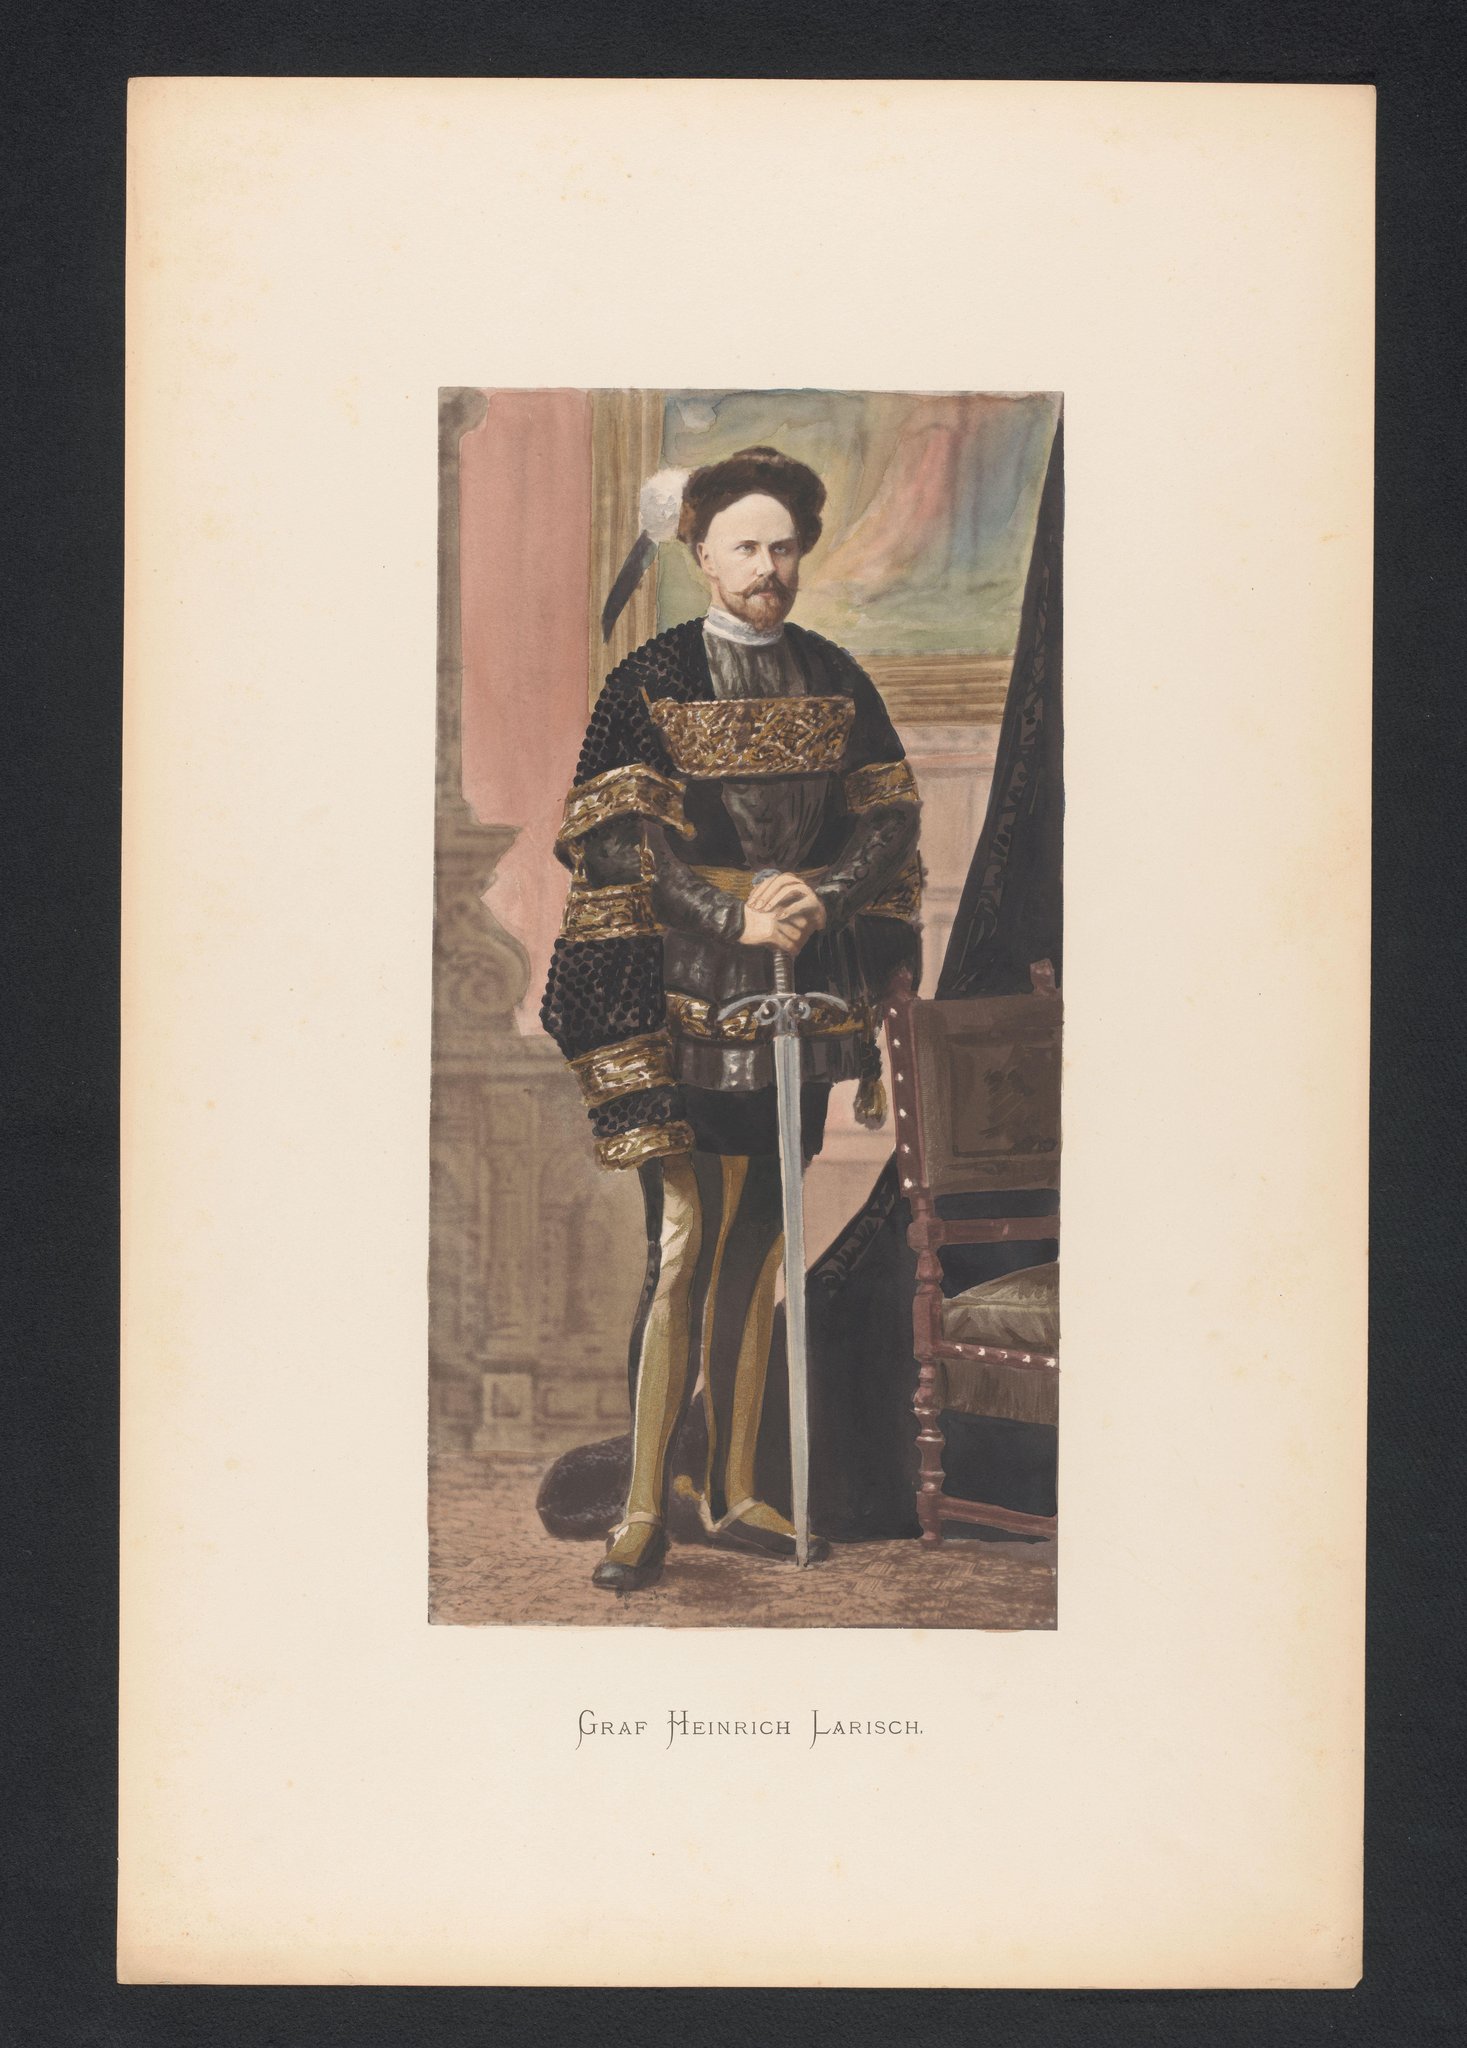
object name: photomechanical print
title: Portret van graaf Heinrich Larisch von Moennich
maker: Anonymous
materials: paper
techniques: photograph, hand coloring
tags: earl, aristocracy; 'aristocratia' (ripa), historical persons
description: Deze prent maakt deel uit van een omslag met 86 prenten op 78 bladen en 11 tekstbladen.